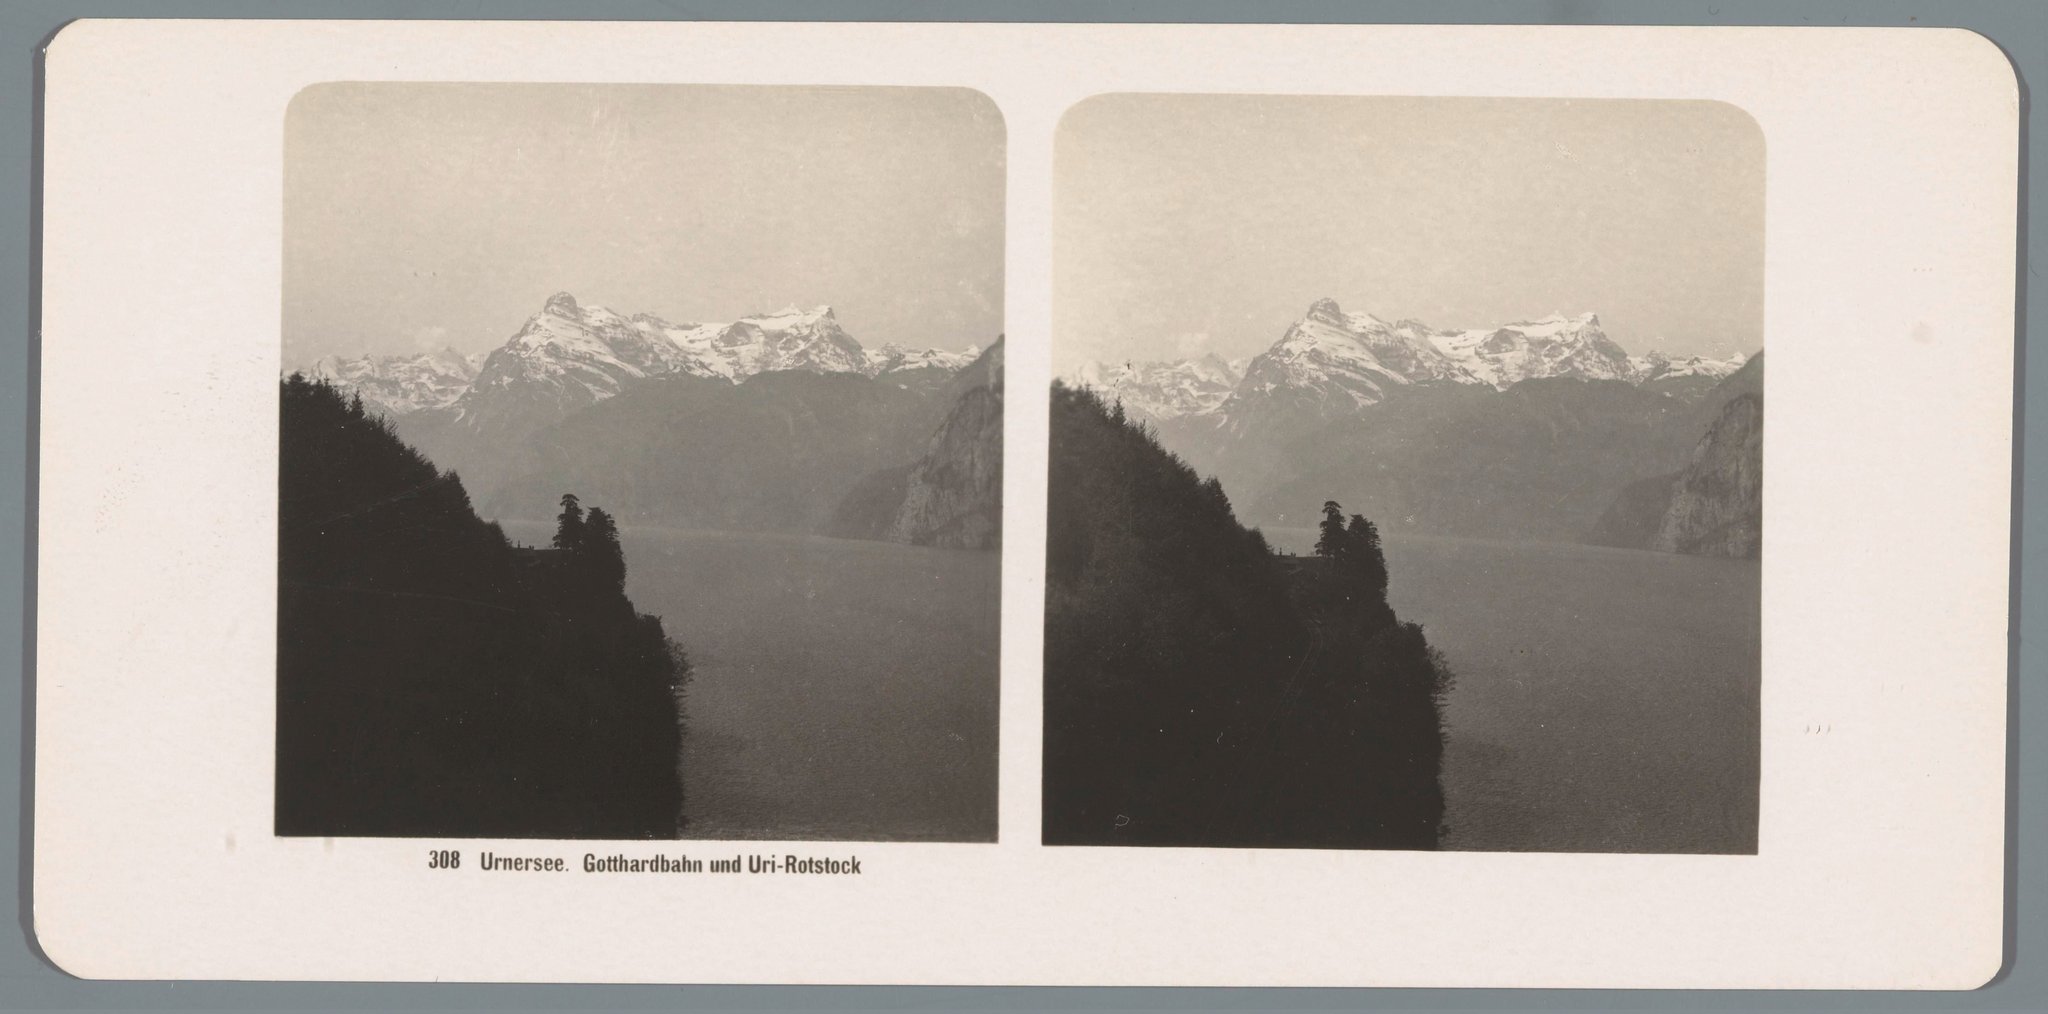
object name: stereograph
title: Gezicht op de Urnersee, met op de achtergrond de Urirotstock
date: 1900-1910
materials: cardboard, photographic support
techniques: gelatin silver print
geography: uri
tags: mountain-top, peak, lake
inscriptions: number: ‘308’, inscription: ‘Wehrli A.-G. Kilchberg-Zürich’